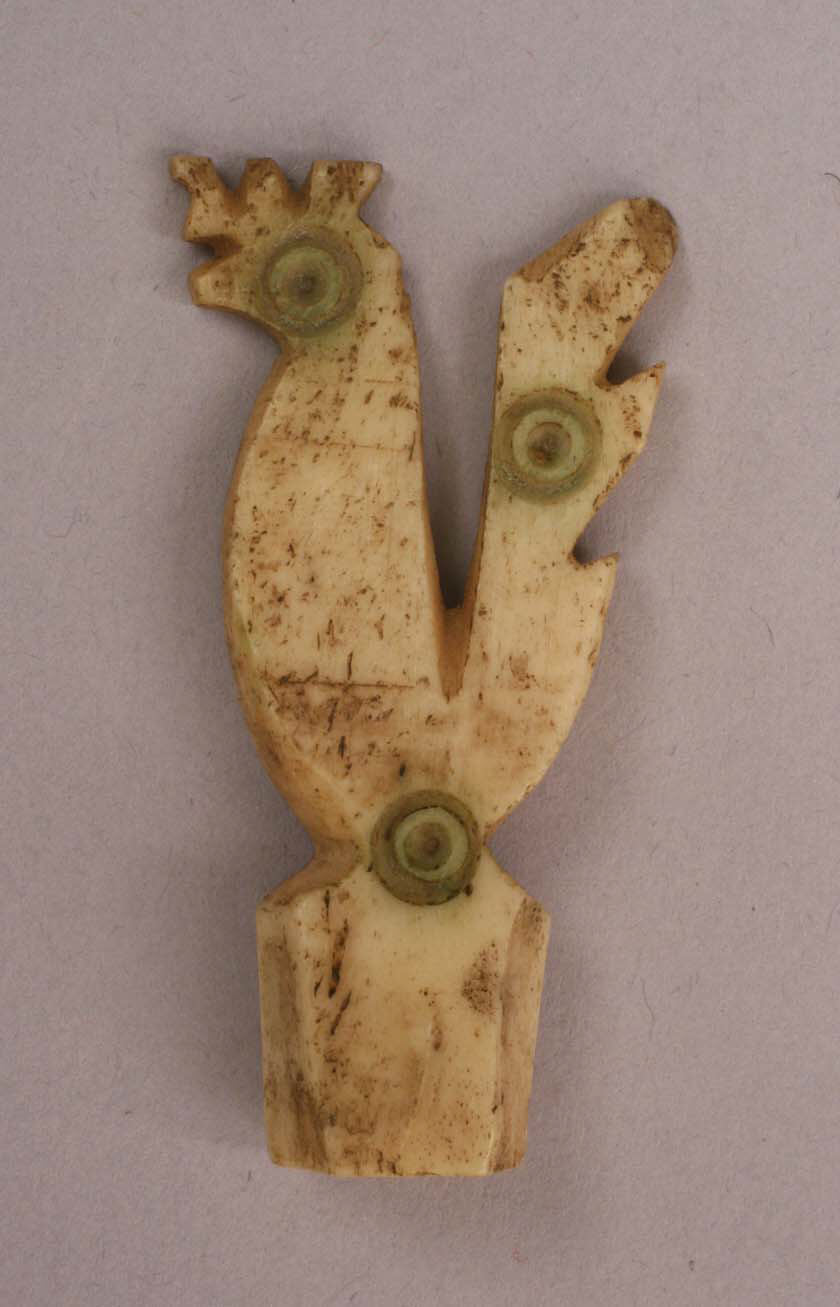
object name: ornament or head of a pin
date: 601-800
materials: bone, paint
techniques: incising, inlay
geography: egypt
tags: birds